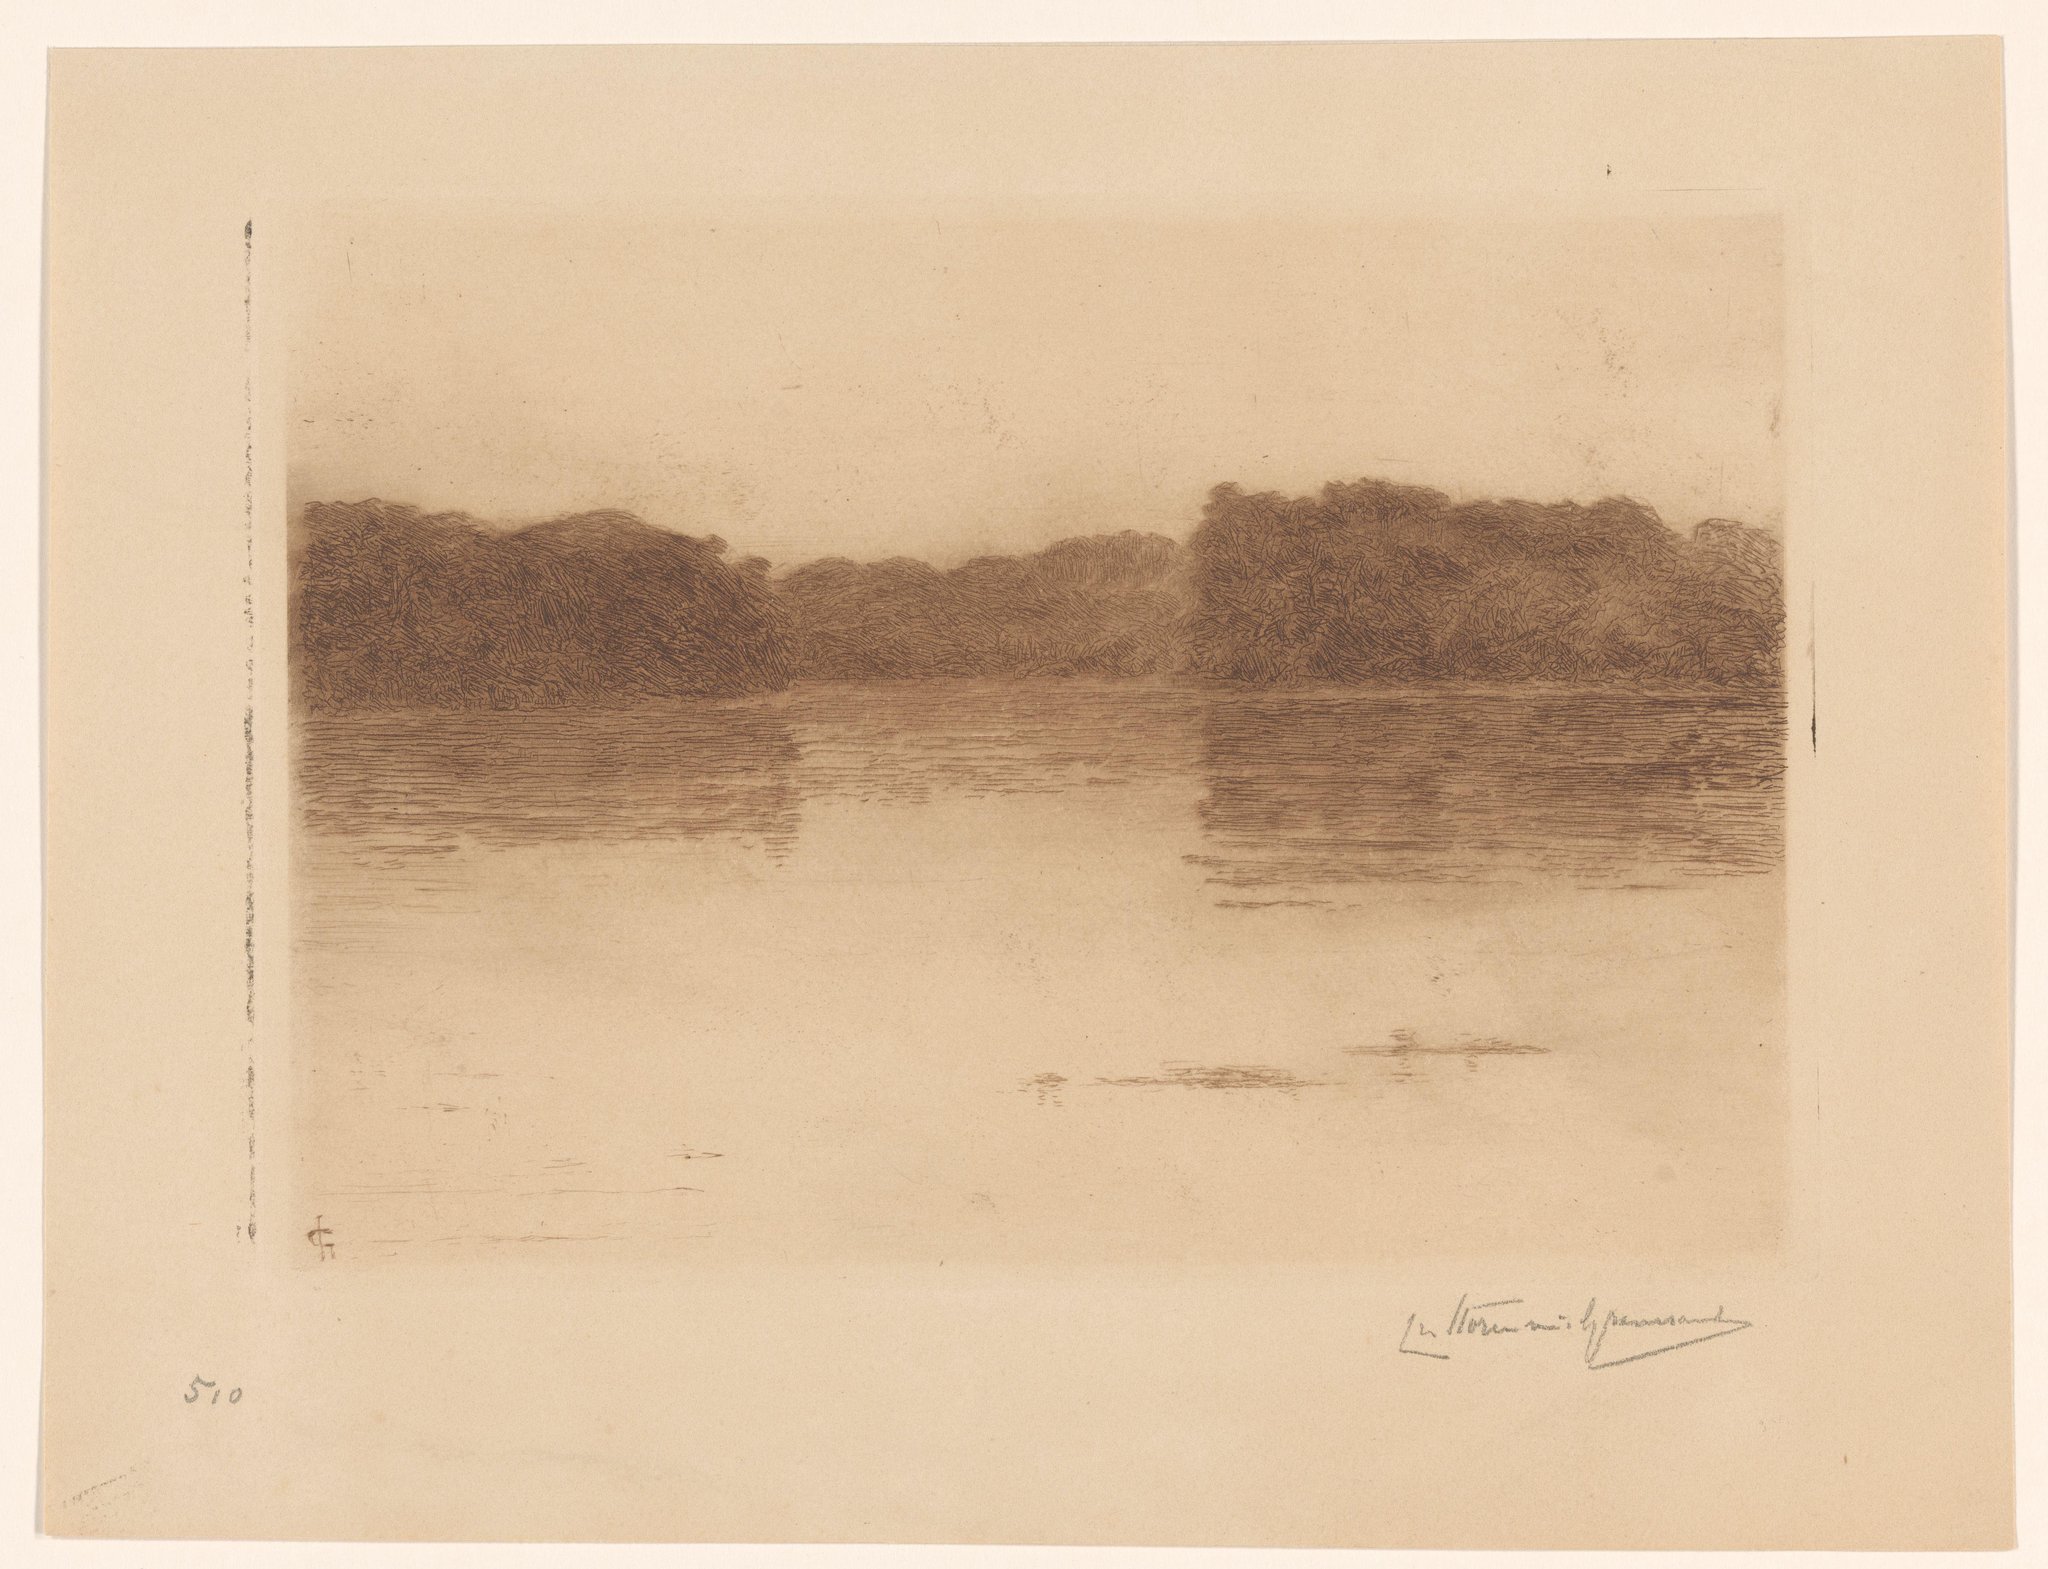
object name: print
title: Vijver in het Haagse Bos bij avond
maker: carel nicolaas storm van s-gravesande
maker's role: draughtsman, print maker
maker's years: 1841-1924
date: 1851-1924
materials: paper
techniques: etching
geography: netherlands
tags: evening, pond, pool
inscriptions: number: ‘510’, collector's mark: Lugt 2228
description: Mogelijk vermeld in: Storm van 's-Gravesande, Charles. Catalogue des eaux-fortes et lithographies. New York: s.n., 1903, of in een onbekende latere uitgave van het manuscript. Vermoedelijk vermeld als catalogusnummer 510.